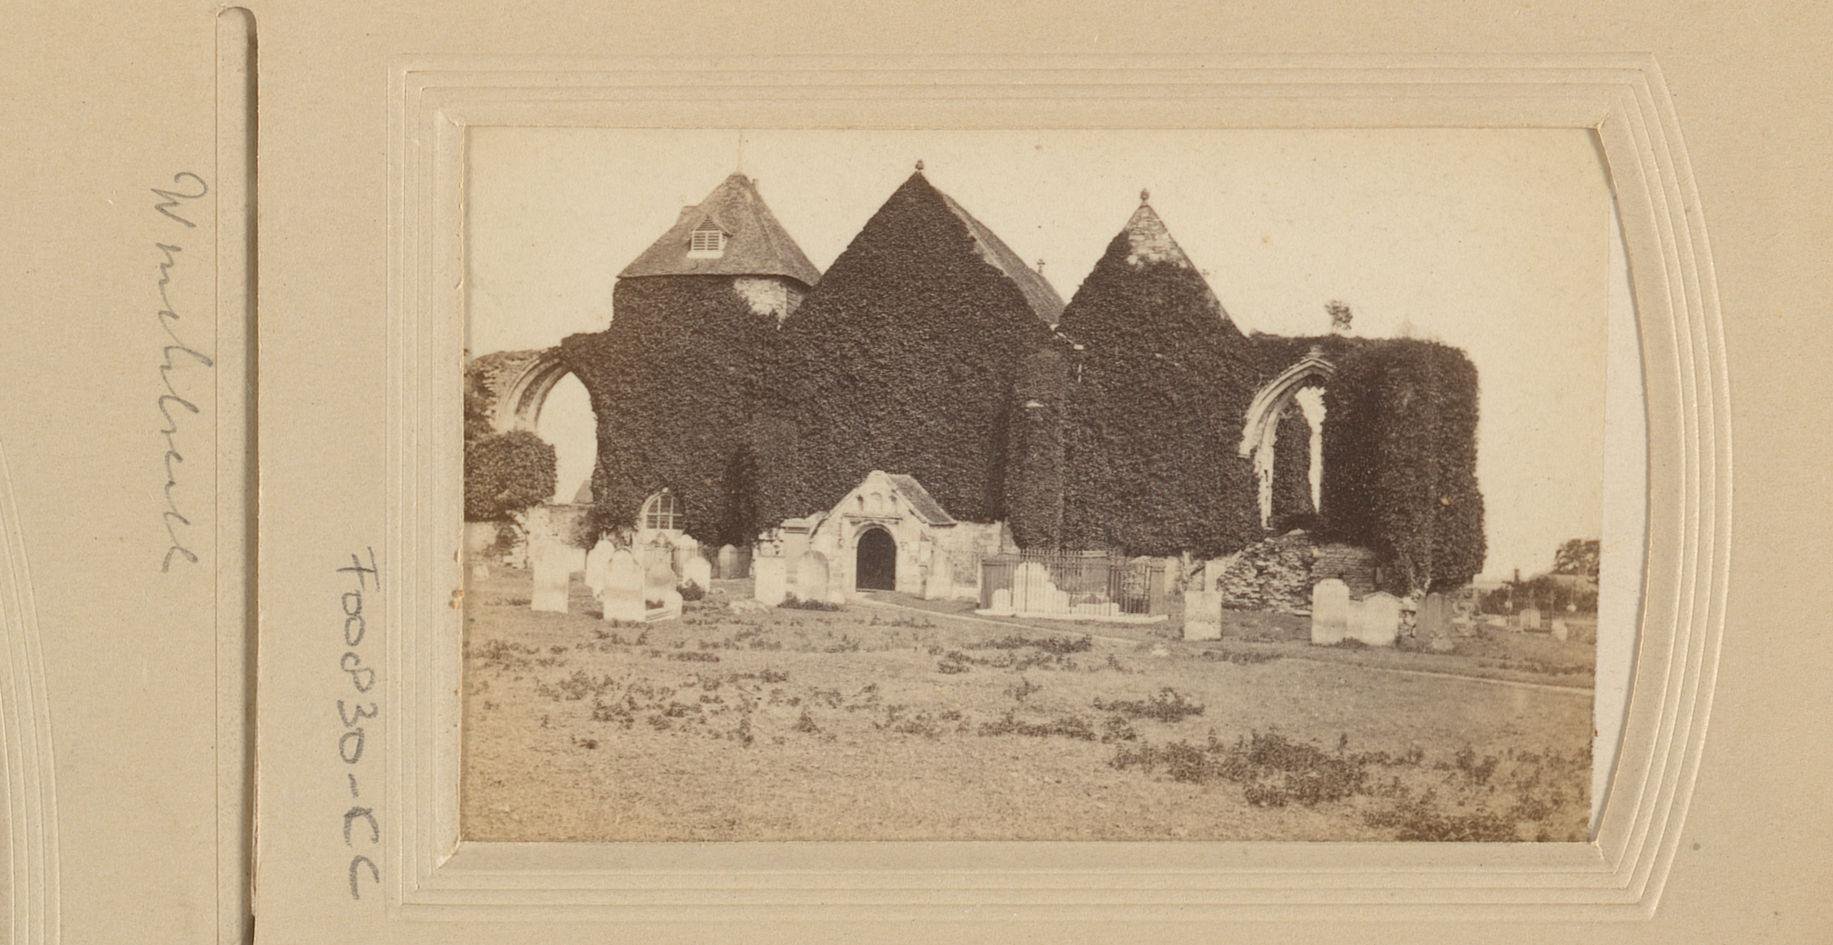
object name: photograph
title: Ruïnes van een gebouw bedek met klimop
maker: frances sutherland mann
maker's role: fotograaf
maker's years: 1867-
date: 1870-1900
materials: cardboard, photographic support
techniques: albumen print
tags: ruin of a dwelling, house, castle, etc., plants and herbs: ivy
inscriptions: inscription: ‘F.S. Mann/ Photographic/ Artist/ 13/ Wellington/ Place/ Hastings/ (...)’, annotation: ‘W[...]’